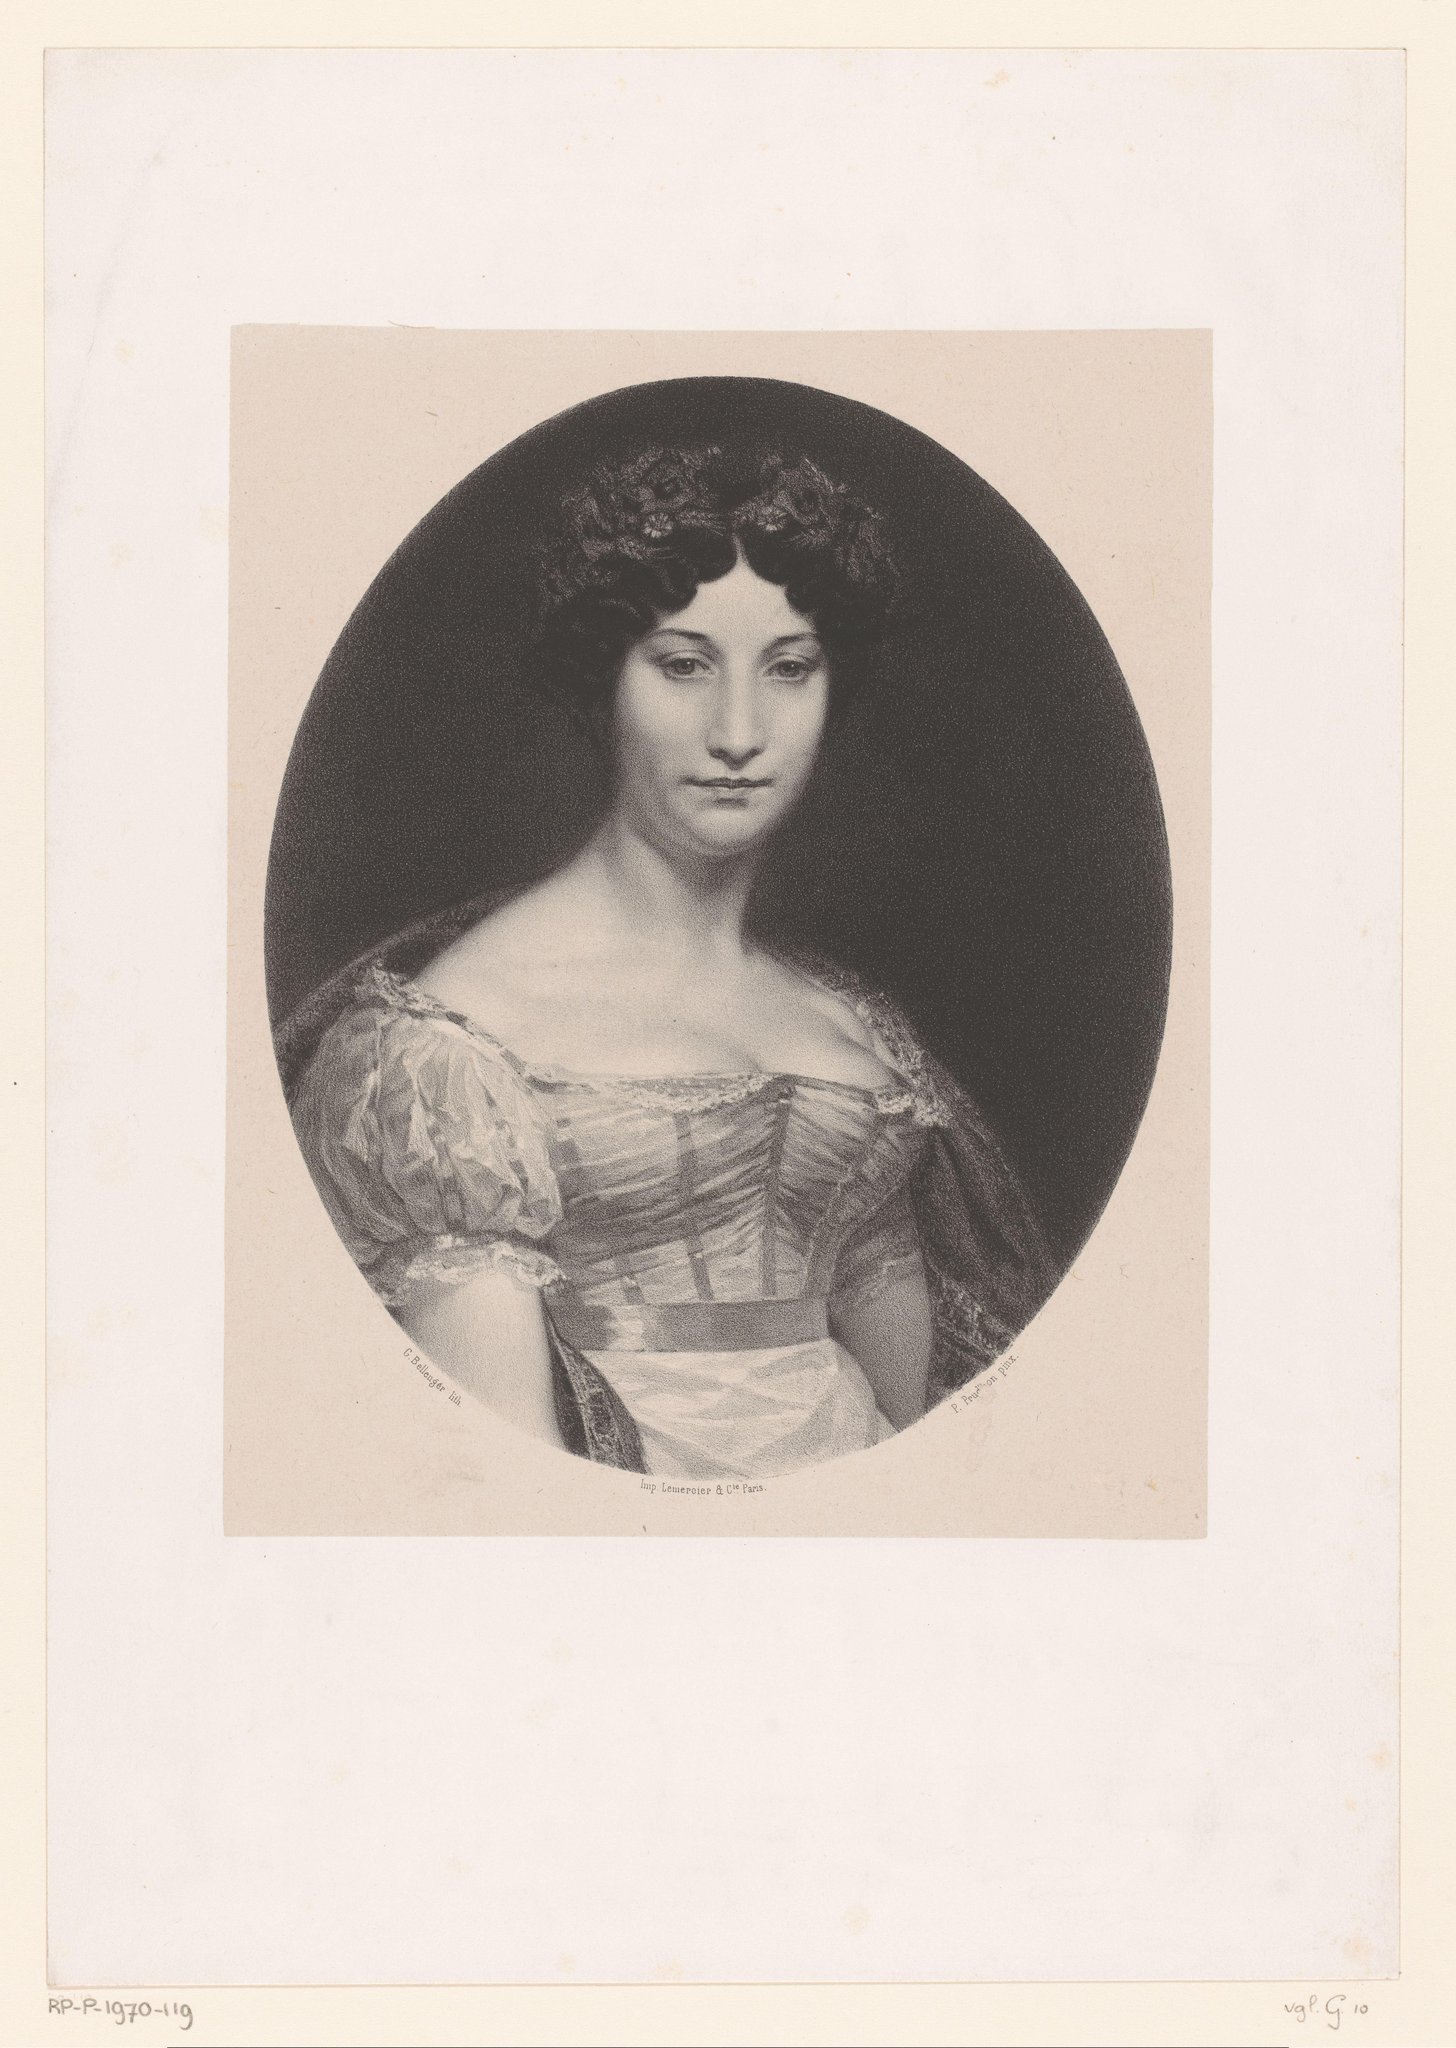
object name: print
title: Portret van Henriette Marguerite Madeleine Jarre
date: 1877-1879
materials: paper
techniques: lithograph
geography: paris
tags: historical persons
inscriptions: collector's mark: Lugt 2228a, collector's mark: Lugt 2760